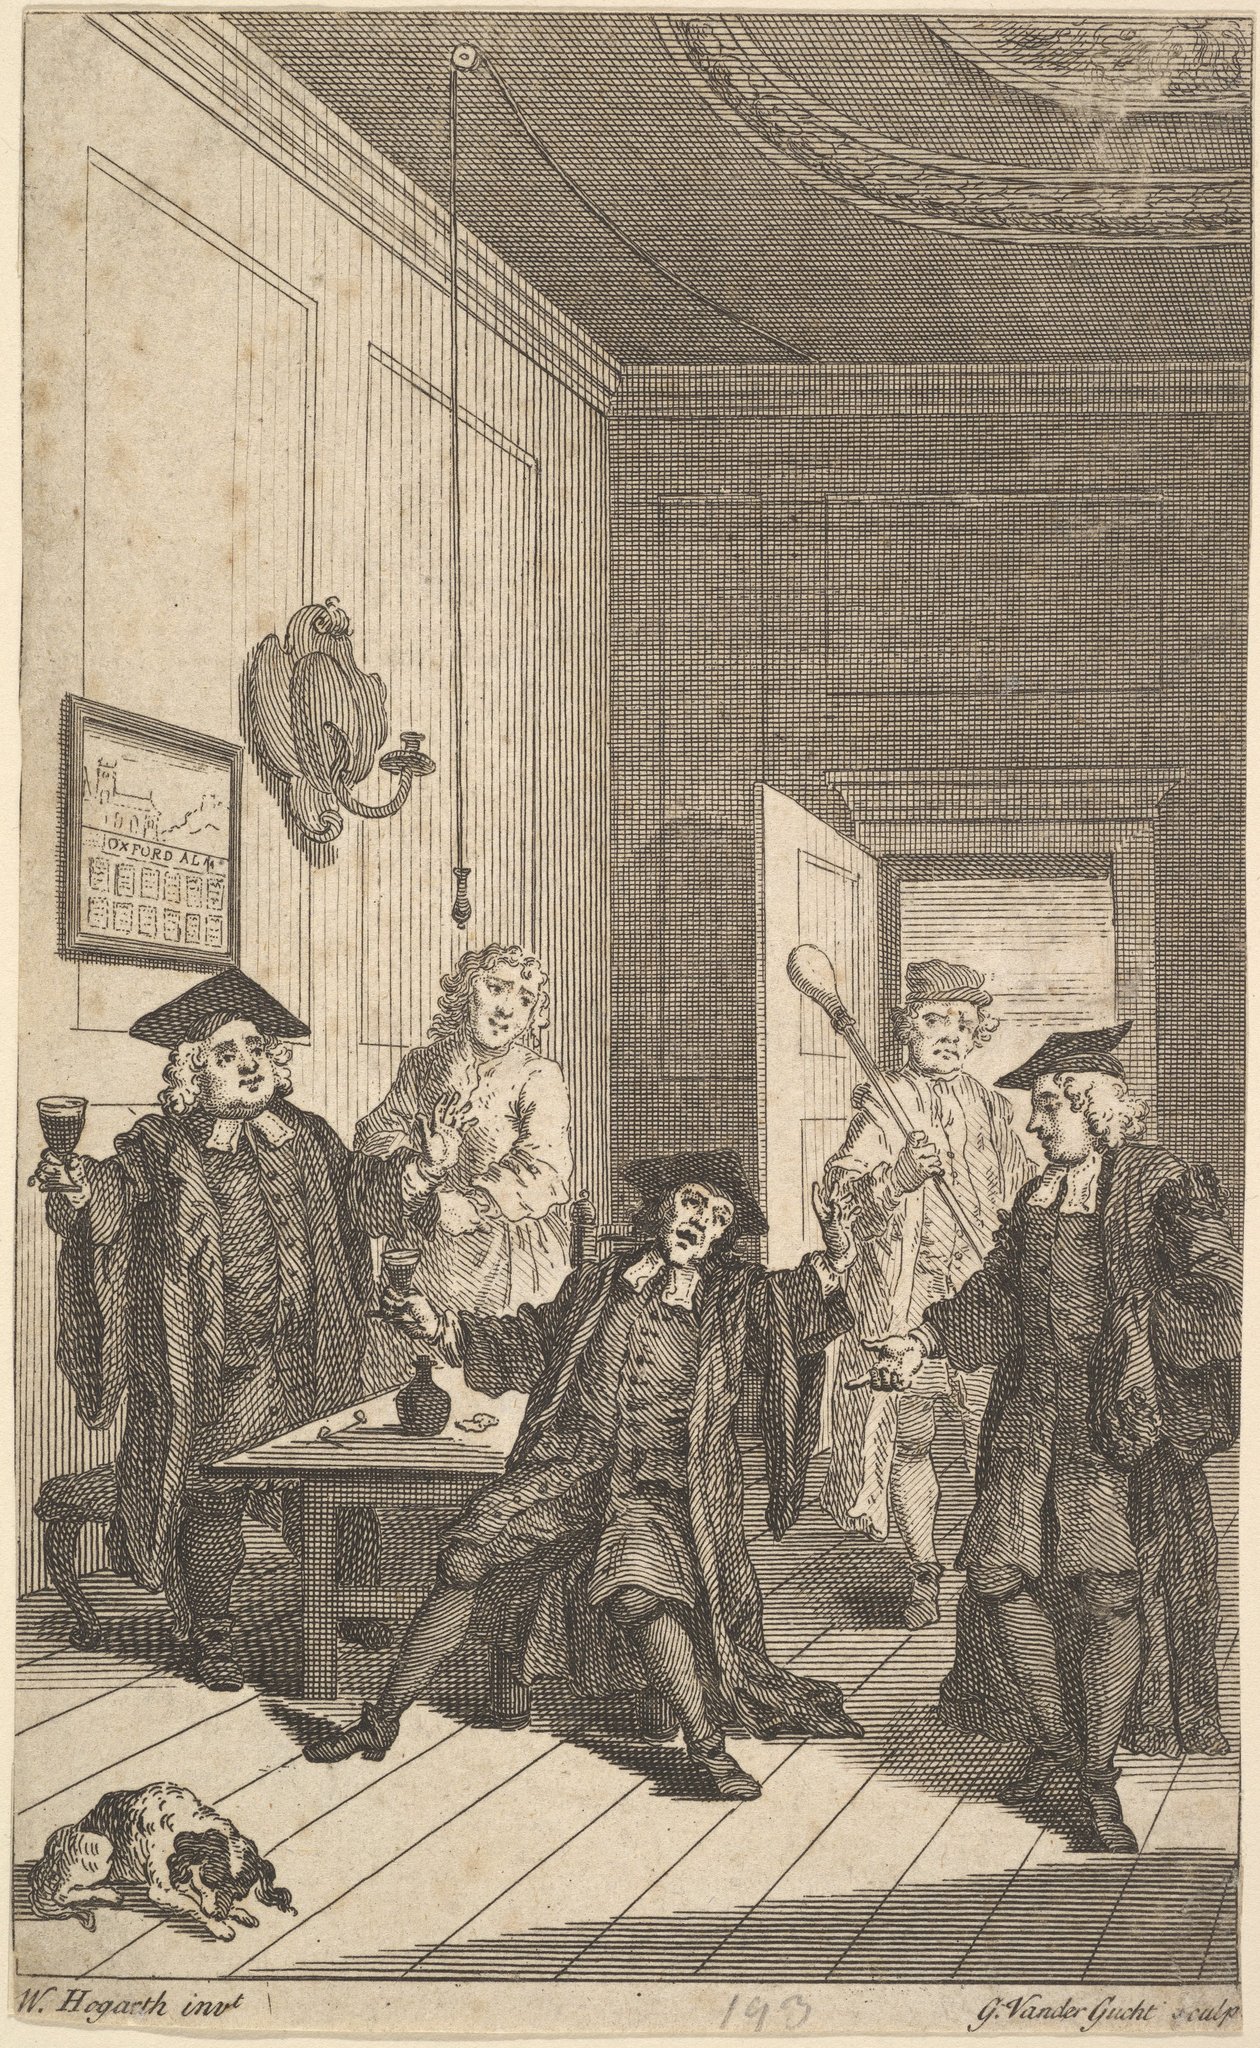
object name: print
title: Frontispiece to "The Humours of Oxford"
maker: gerard vandergucht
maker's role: etcher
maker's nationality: british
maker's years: 1696-1776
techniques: engraving, etching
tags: men,dogs,drinking